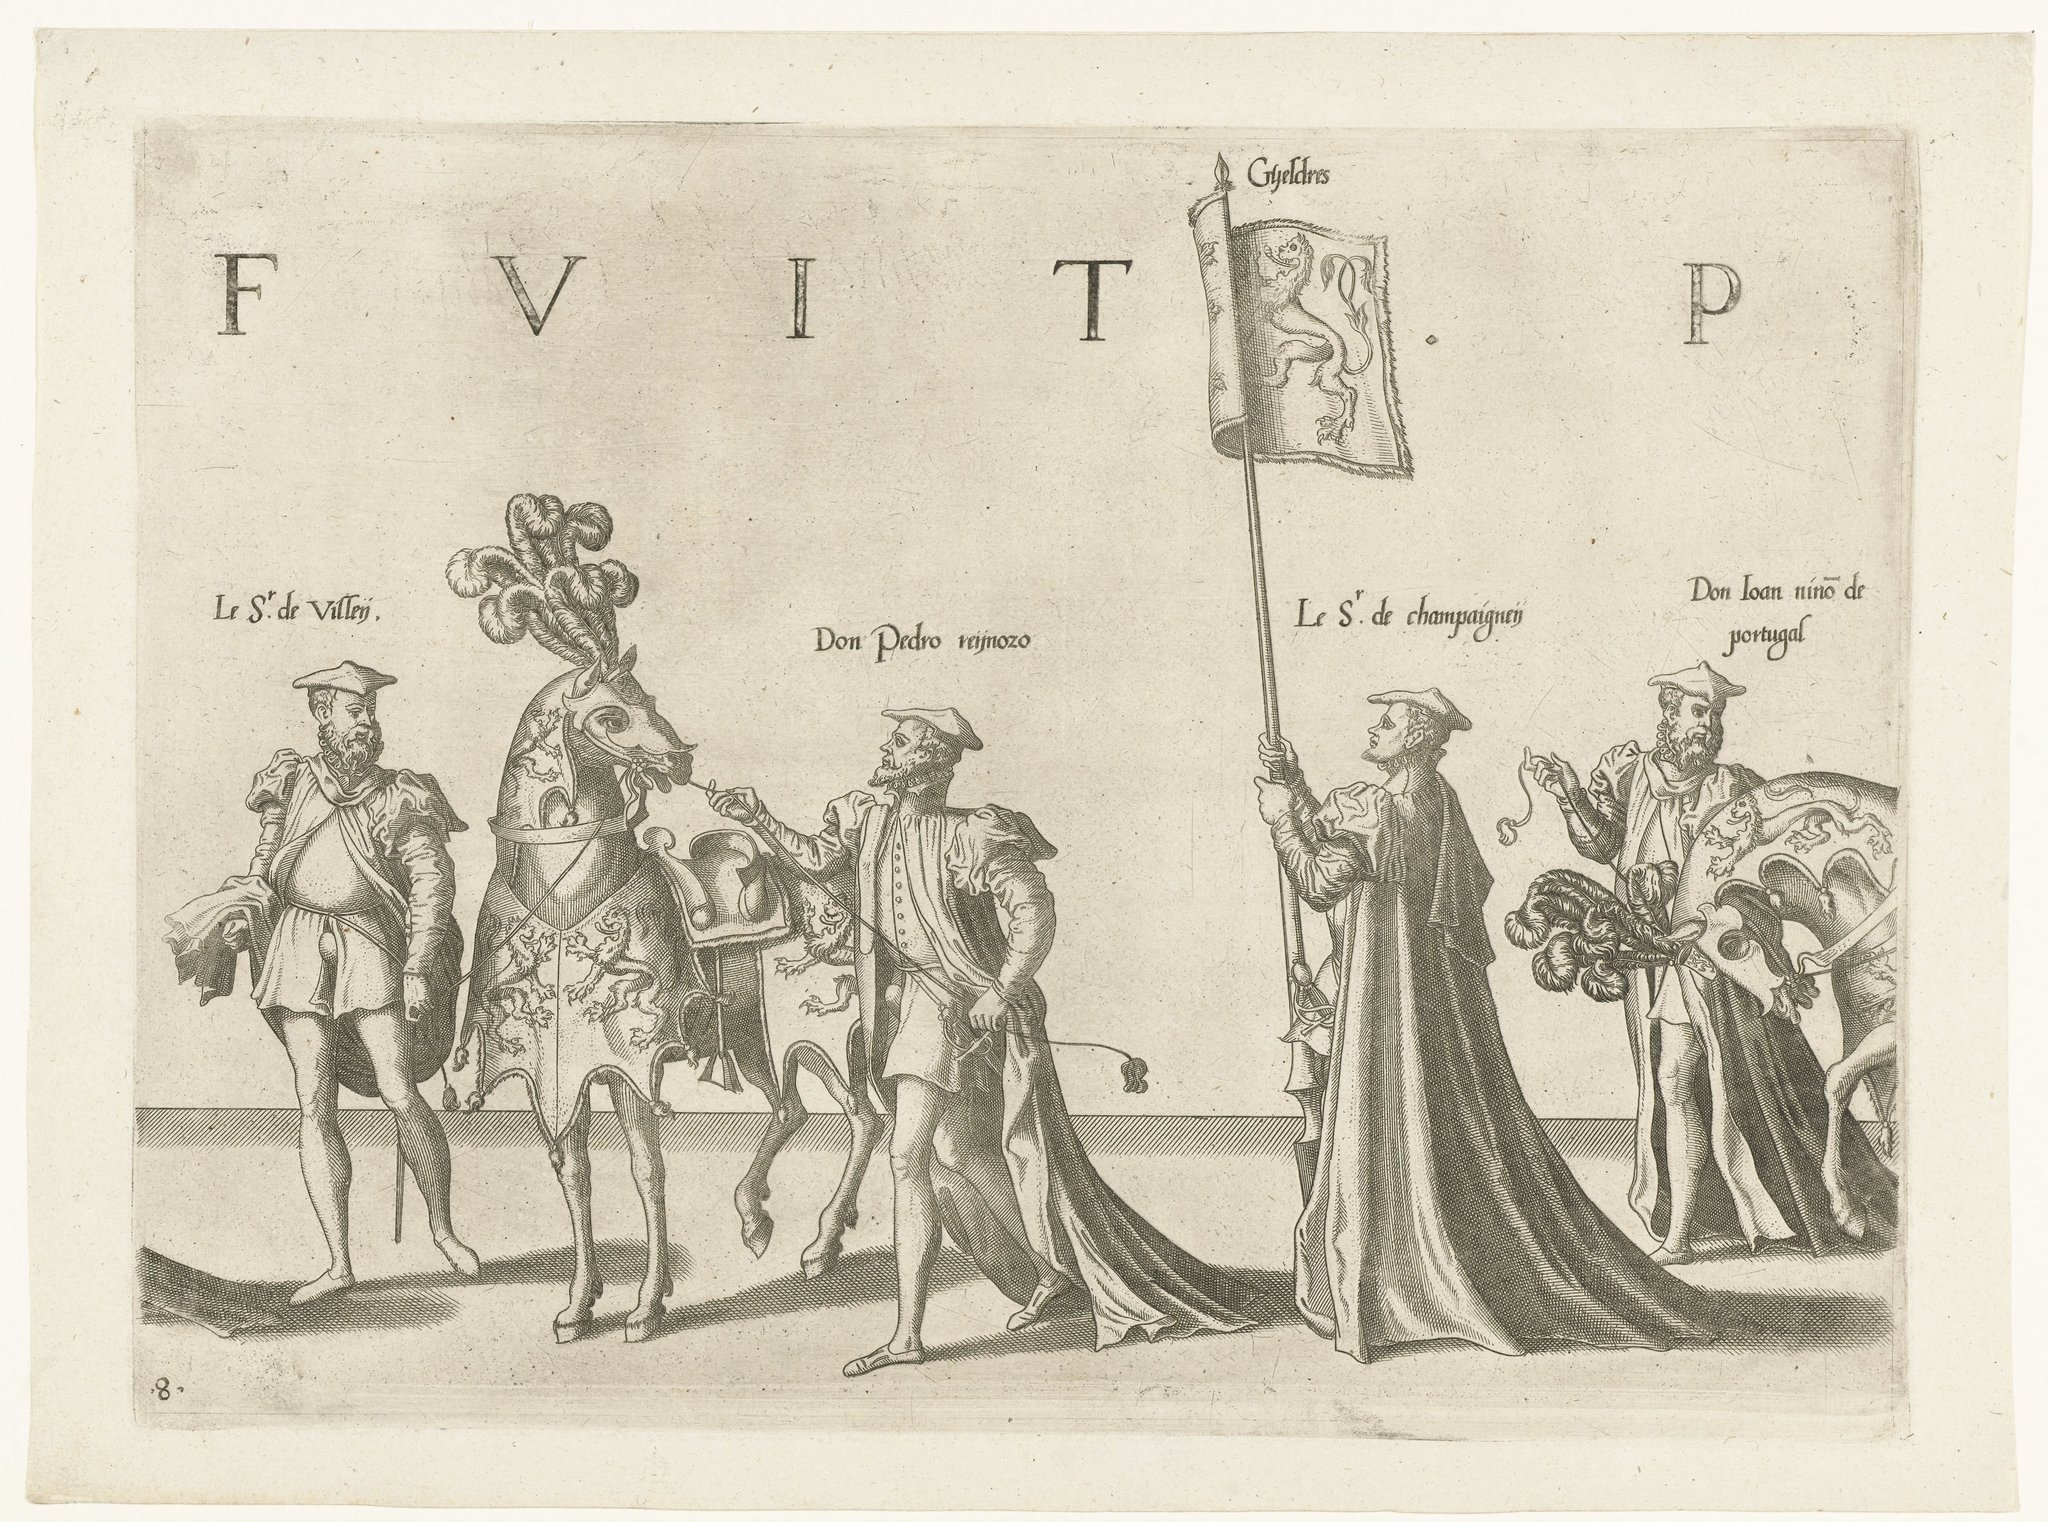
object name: print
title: Deel van de optocht, nr. 8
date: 1559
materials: paper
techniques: engraving, etching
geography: southern netherlands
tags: ghent, charles v (holy roman emperor and king of spain), cortege, funeral procession, brussels, guelders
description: Vier deelnemers aan de optocht, paarden en het vaandel met het wapen van Gelre. Onderdeel van de prentreeks van de Begrafenisoptocht van keizer Karel V op 29 december 1558 te Brussel.